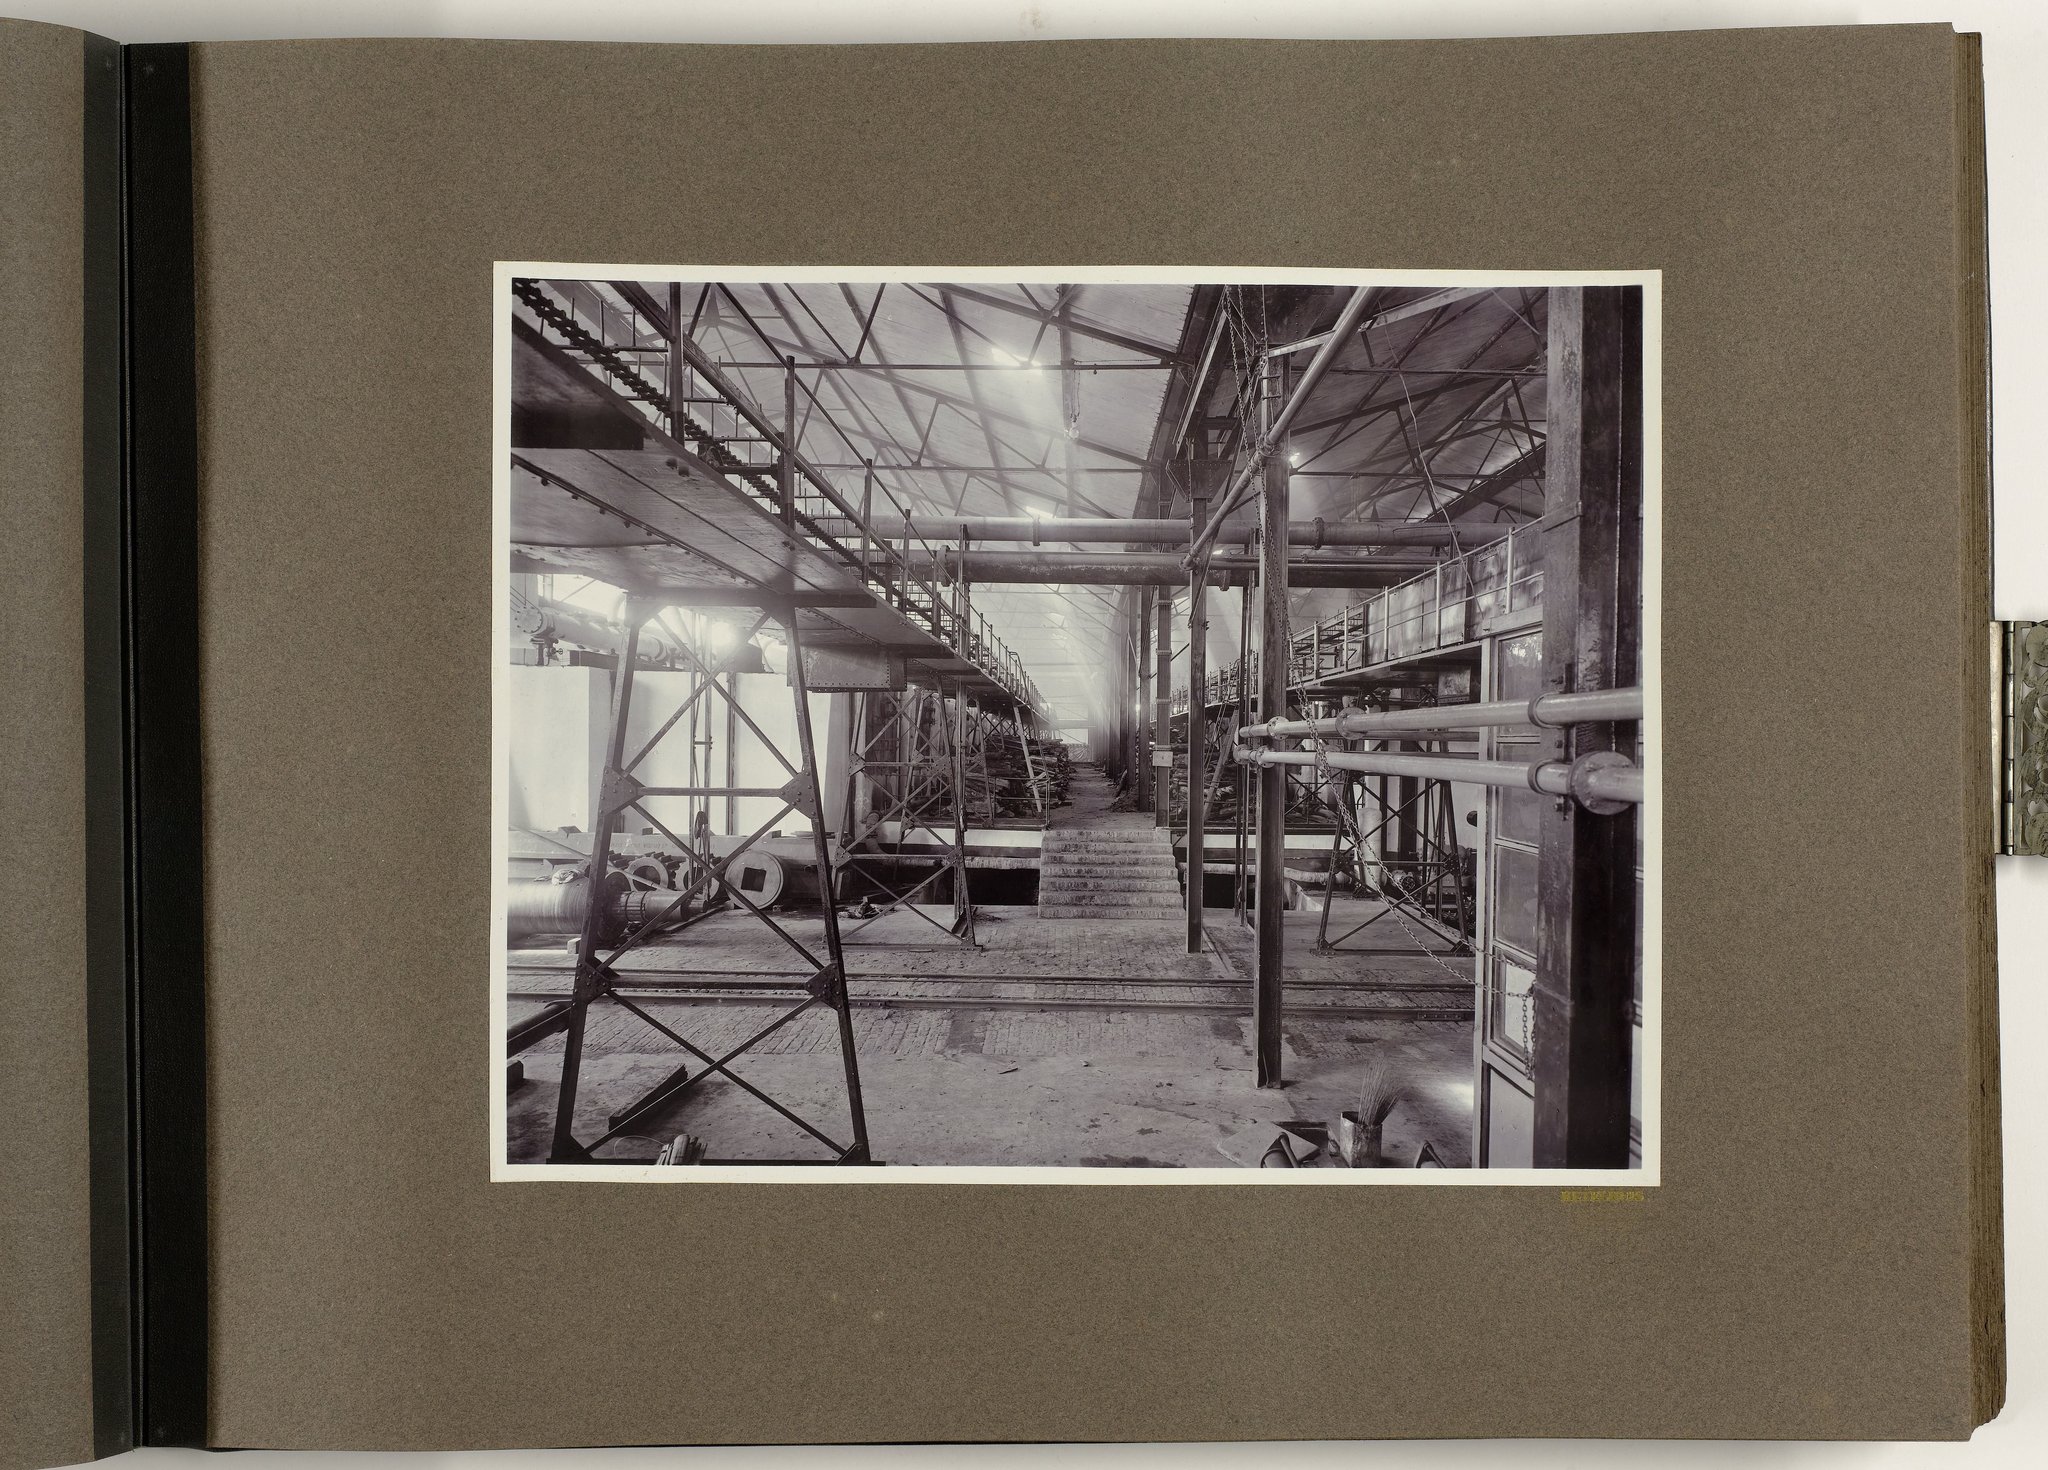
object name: photograph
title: Ketelhuis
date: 1917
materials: photographic support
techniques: gelatin silver print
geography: jatiroto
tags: colonial system, (non-fruit) products of plants or trees: sugarcane, interior of industrial structures (regardless of the materials processed or the products made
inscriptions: inscription: ‘KETELHUIS’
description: Ketelhuis in de suikerfabriek. Onderdeel van het fotoalbum aangeboden aan F.J. Wirix door het personeel van de Suikeronderneming Djatiroto in 1917.